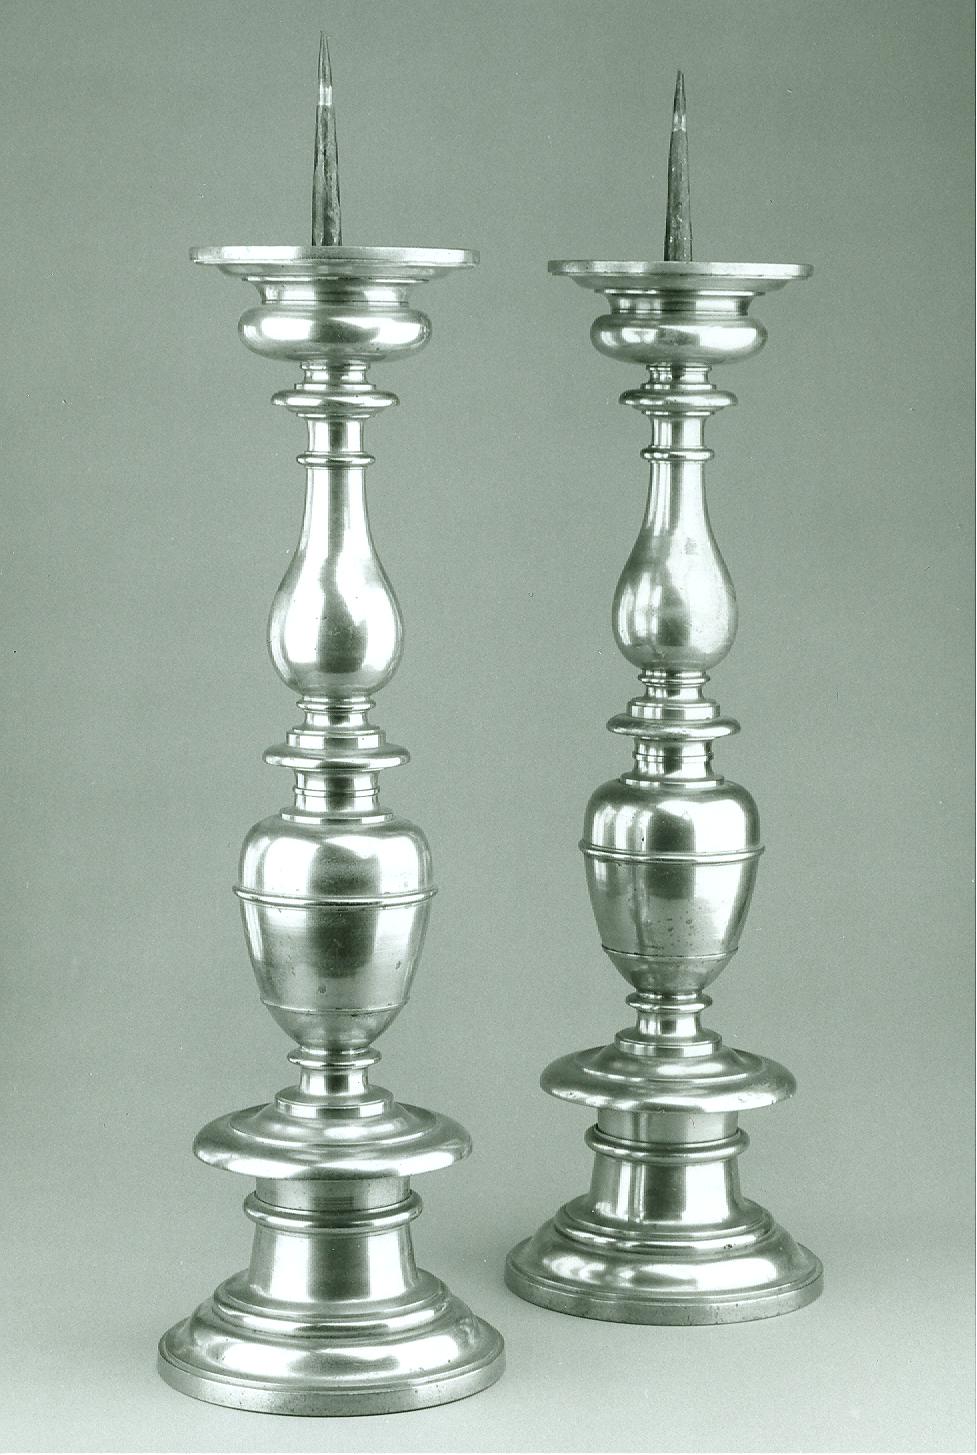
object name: candlestick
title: Altar Candlestick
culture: german or south netherlandish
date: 1601-1700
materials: brass